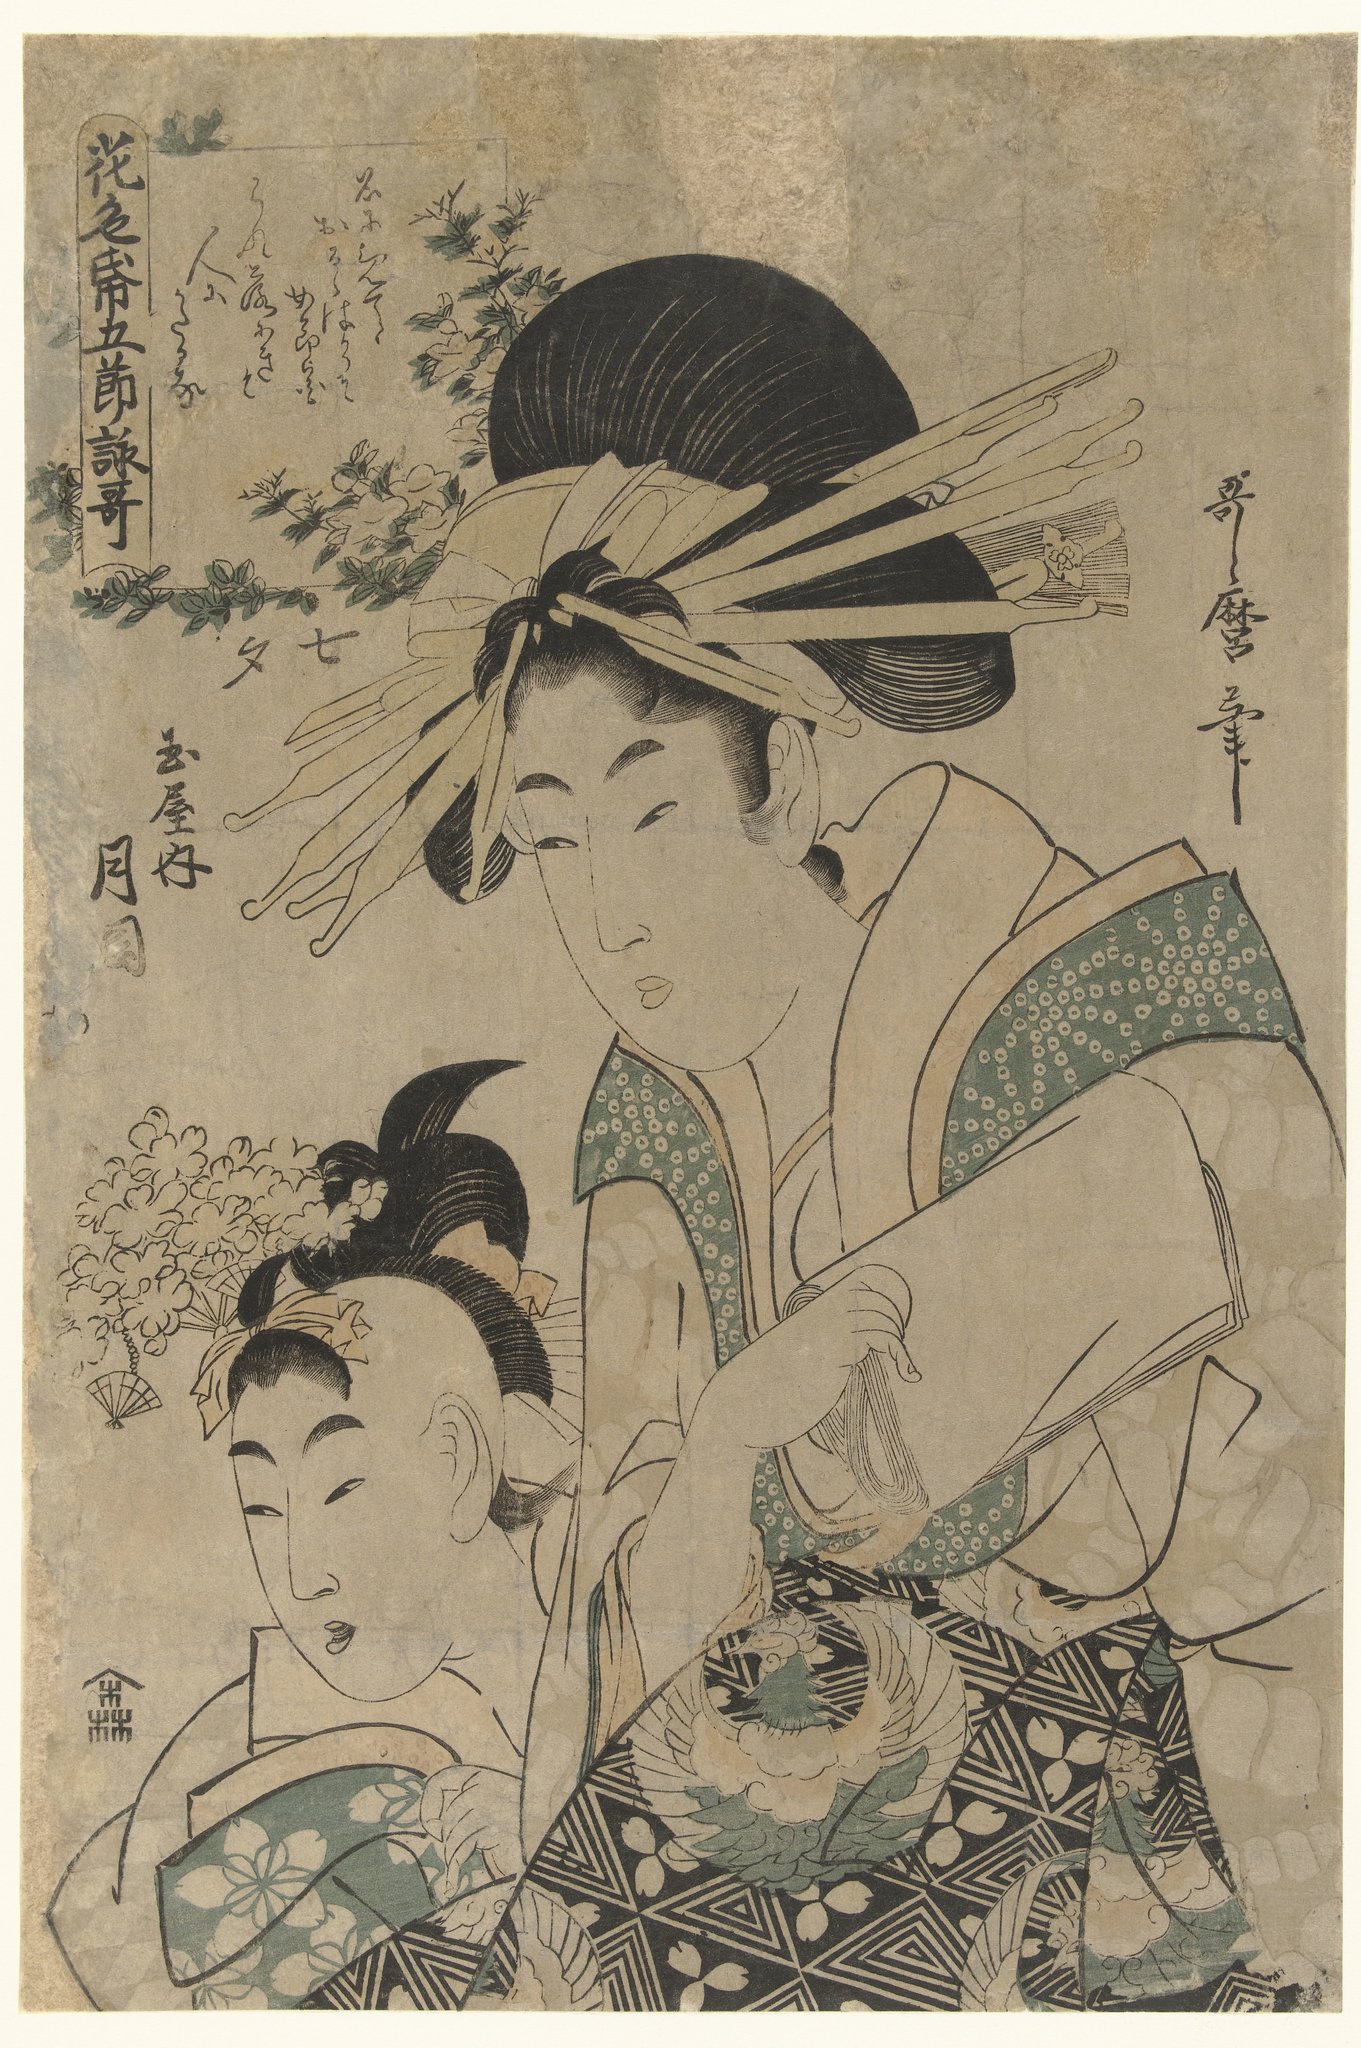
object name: print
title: Tanabata: De courtisane Tsukioka uit het Tamaya huis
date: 1806-1812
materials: paper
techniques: woodcut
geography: tokyo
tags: courtesan, hetaera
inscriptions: collector's mark: Lugt 2228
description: Courtisane, met bundel papier in rechter hand, vergezeld van haar kamuro (jongste bediende van een courtisane).